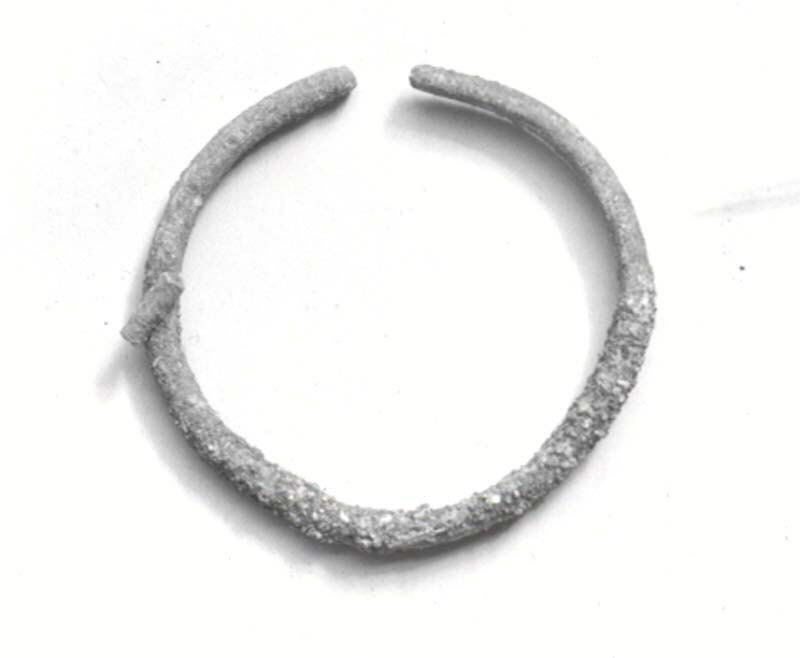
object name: bracelet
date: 2000-1785 BCE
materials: bronze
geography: lebanon